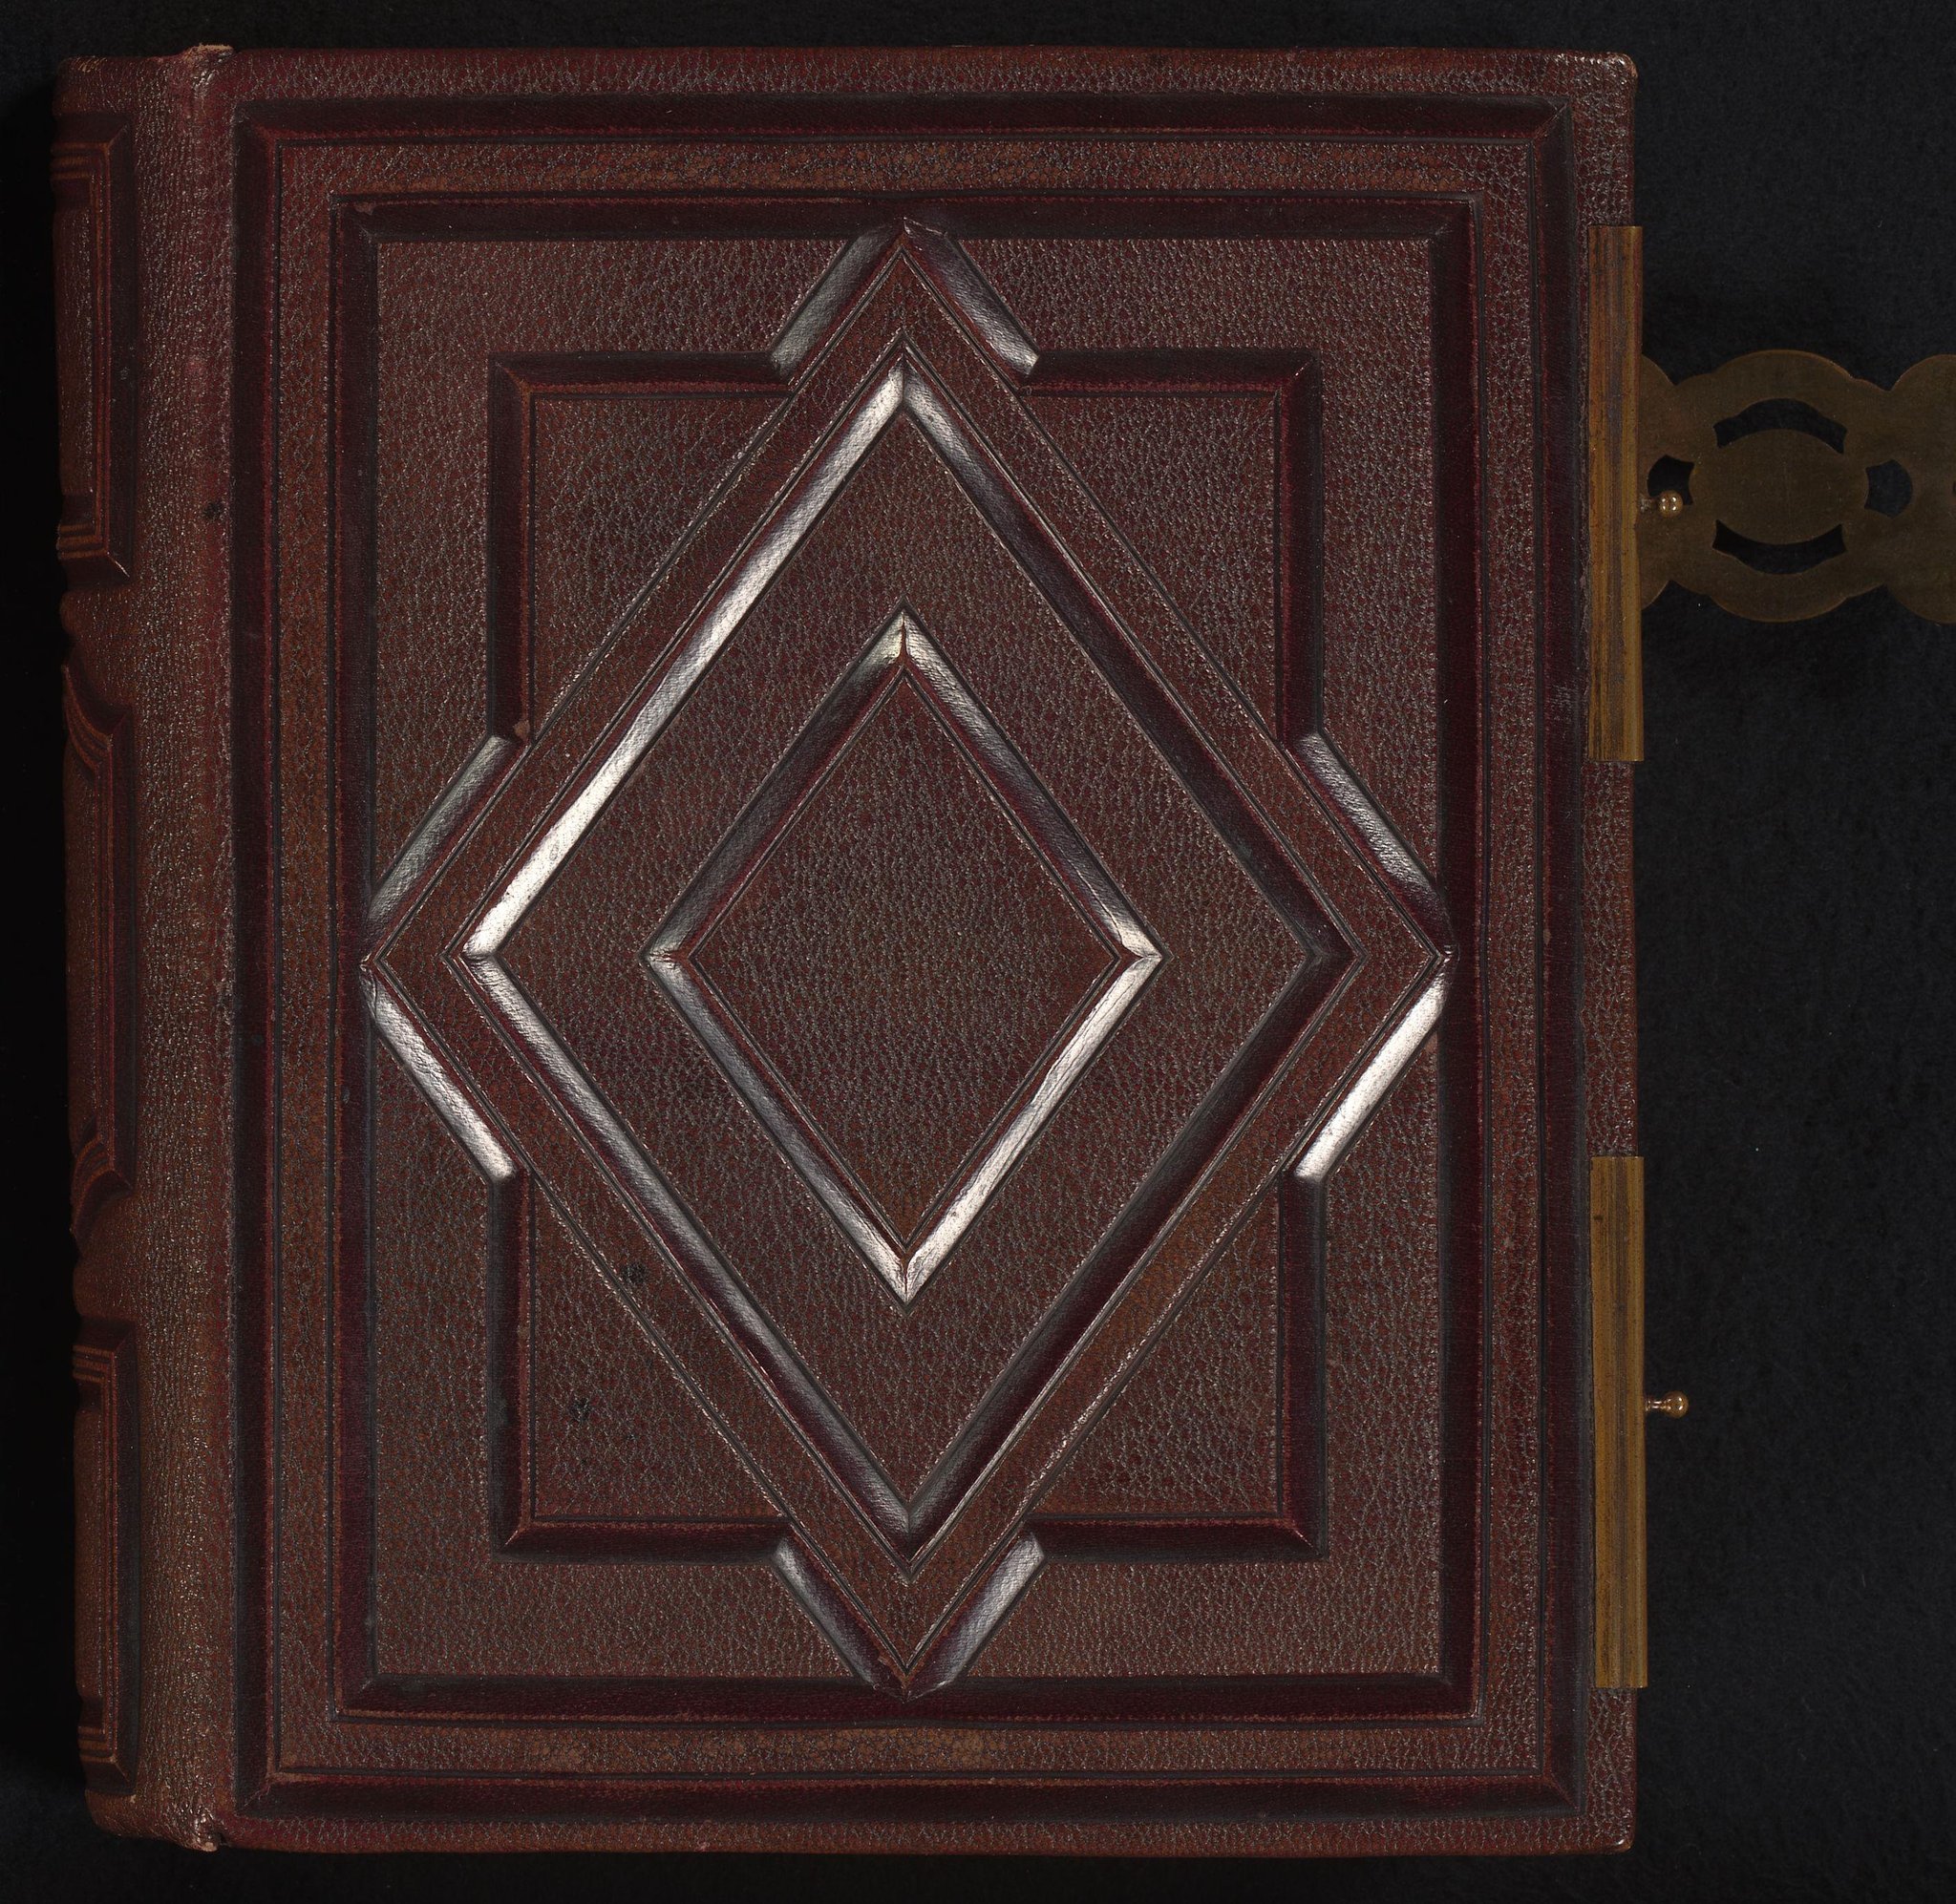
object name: slip in album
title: Familiealbum met 50 foto's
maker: Anonymous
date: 1855-1905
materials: cardboard, leather, metal, photographic support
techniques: albumen print, hand coloring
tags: adult woman, adult man, historical persons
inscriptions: inscription: ‘Dienst Verspreide Rijkskollekties; (...)’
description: Fotoalbum met 25 bladen met in totaal 50 foto's, alle cartes-de-visite. Het album bevat portretten.